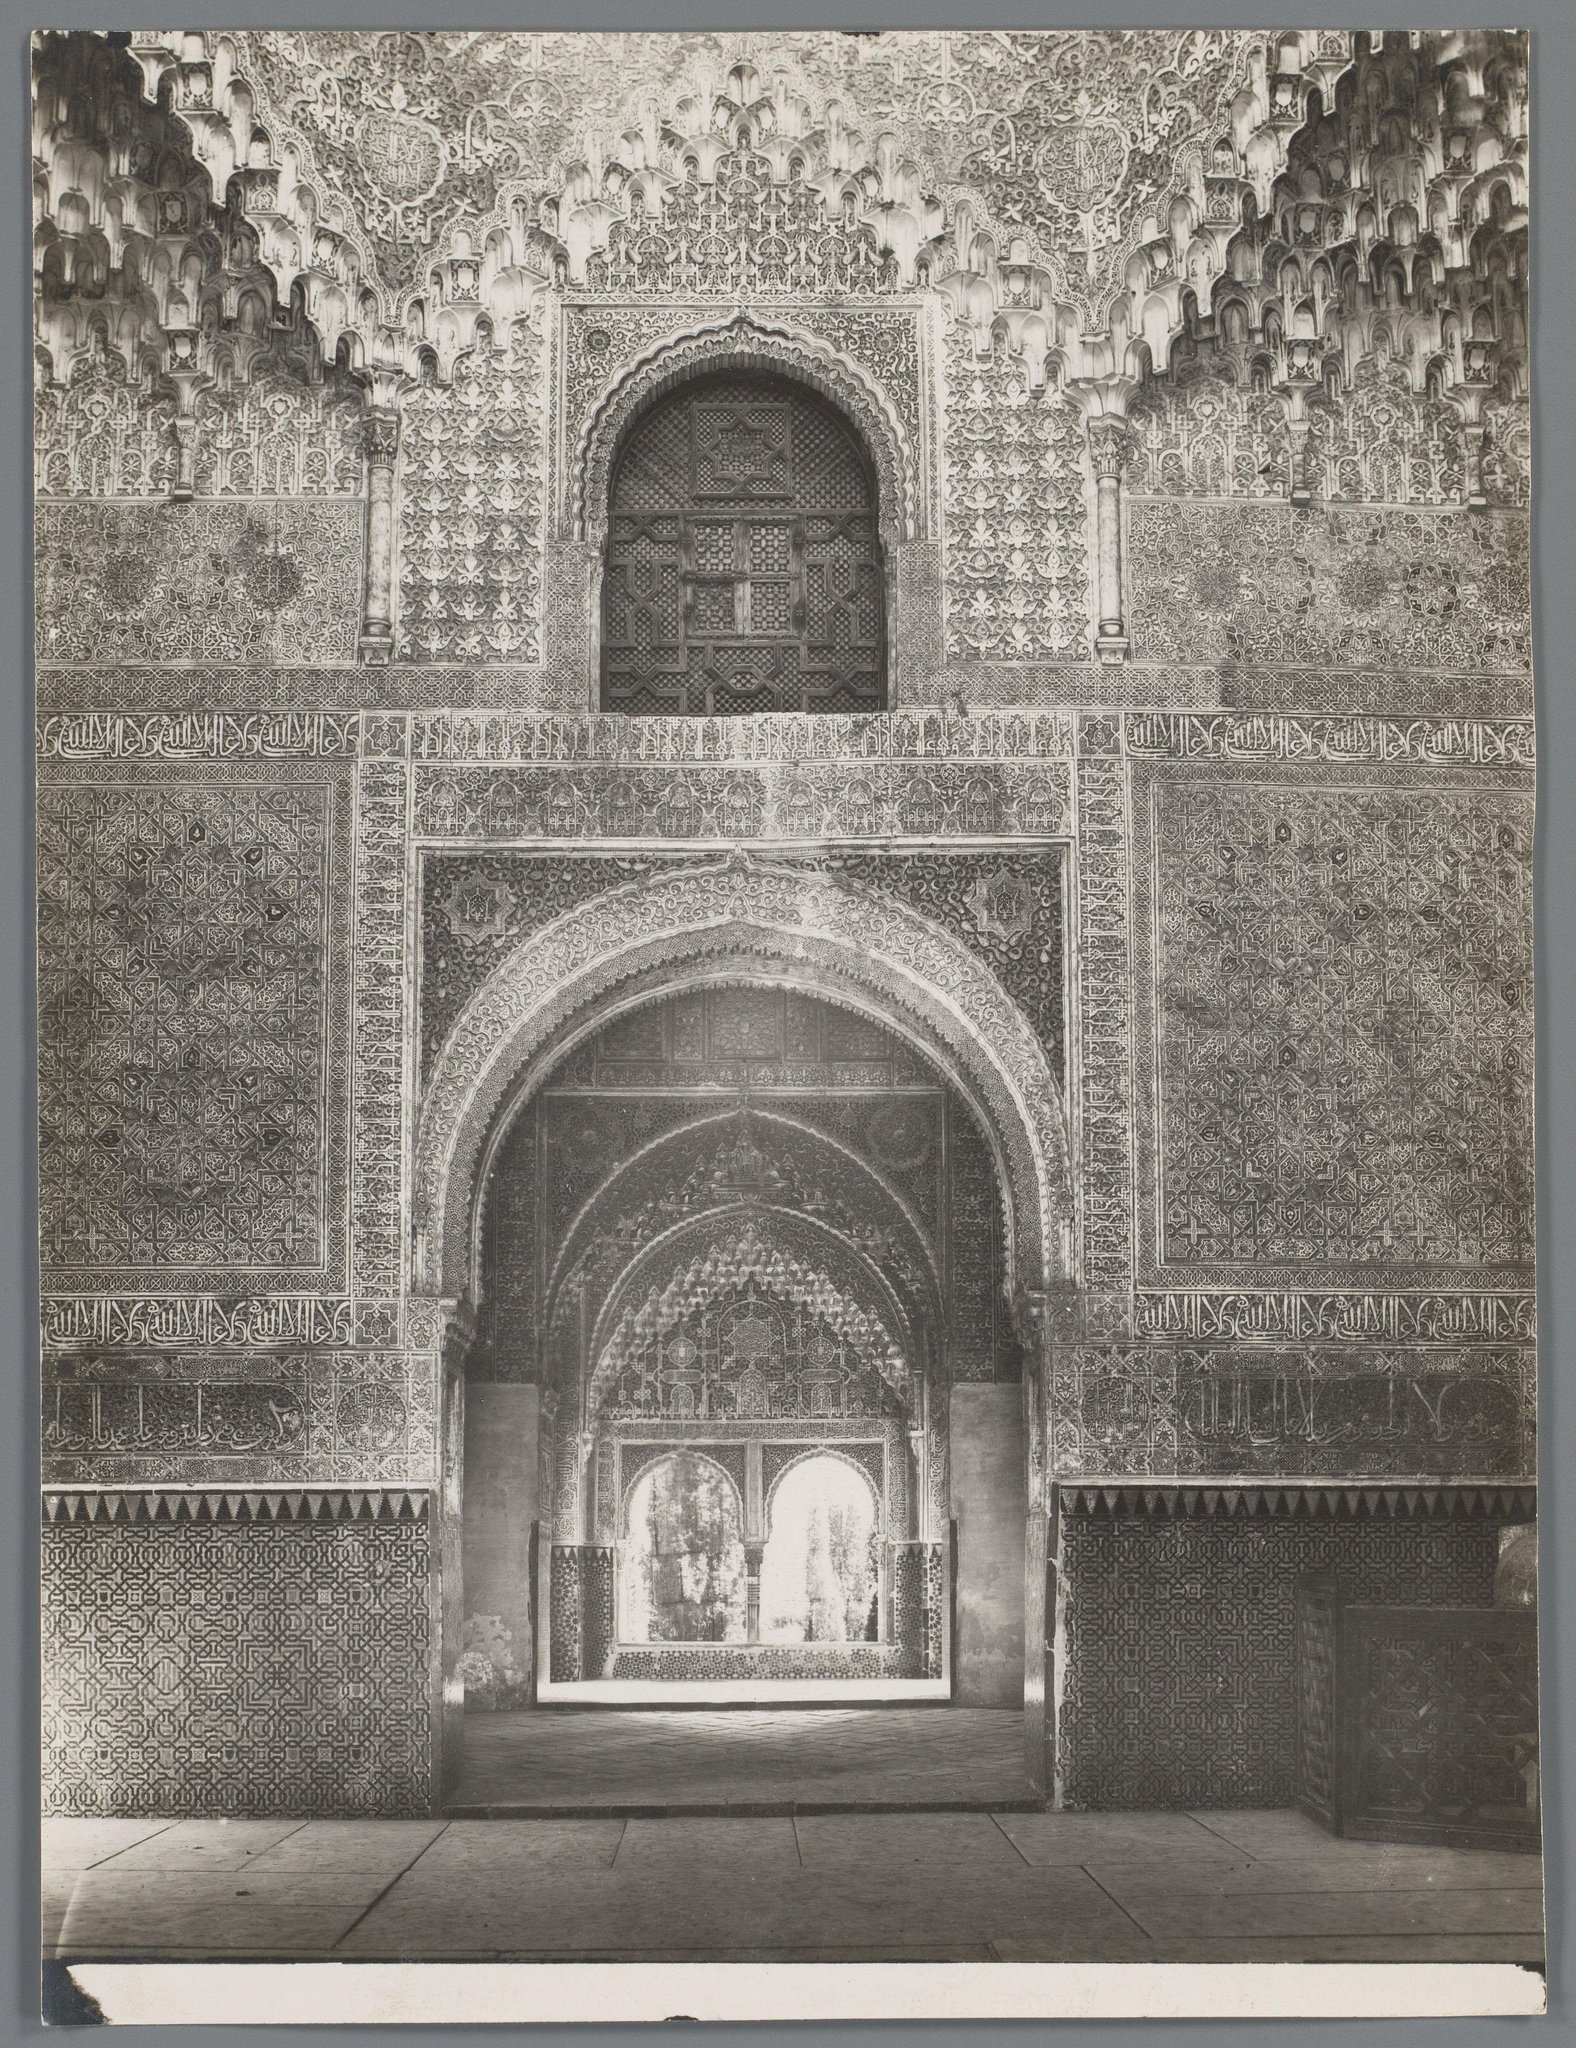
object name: photograph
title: Mirandor de Lindaraja in het Alhambra te Granada, Spanje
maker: f. linares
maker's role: publisher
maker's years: 1870-1937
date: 1914-1937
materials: photographic support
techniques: gelatin silver print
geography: alhambra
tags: fortress, palace, stuccoeing, interior ~ representation of a building